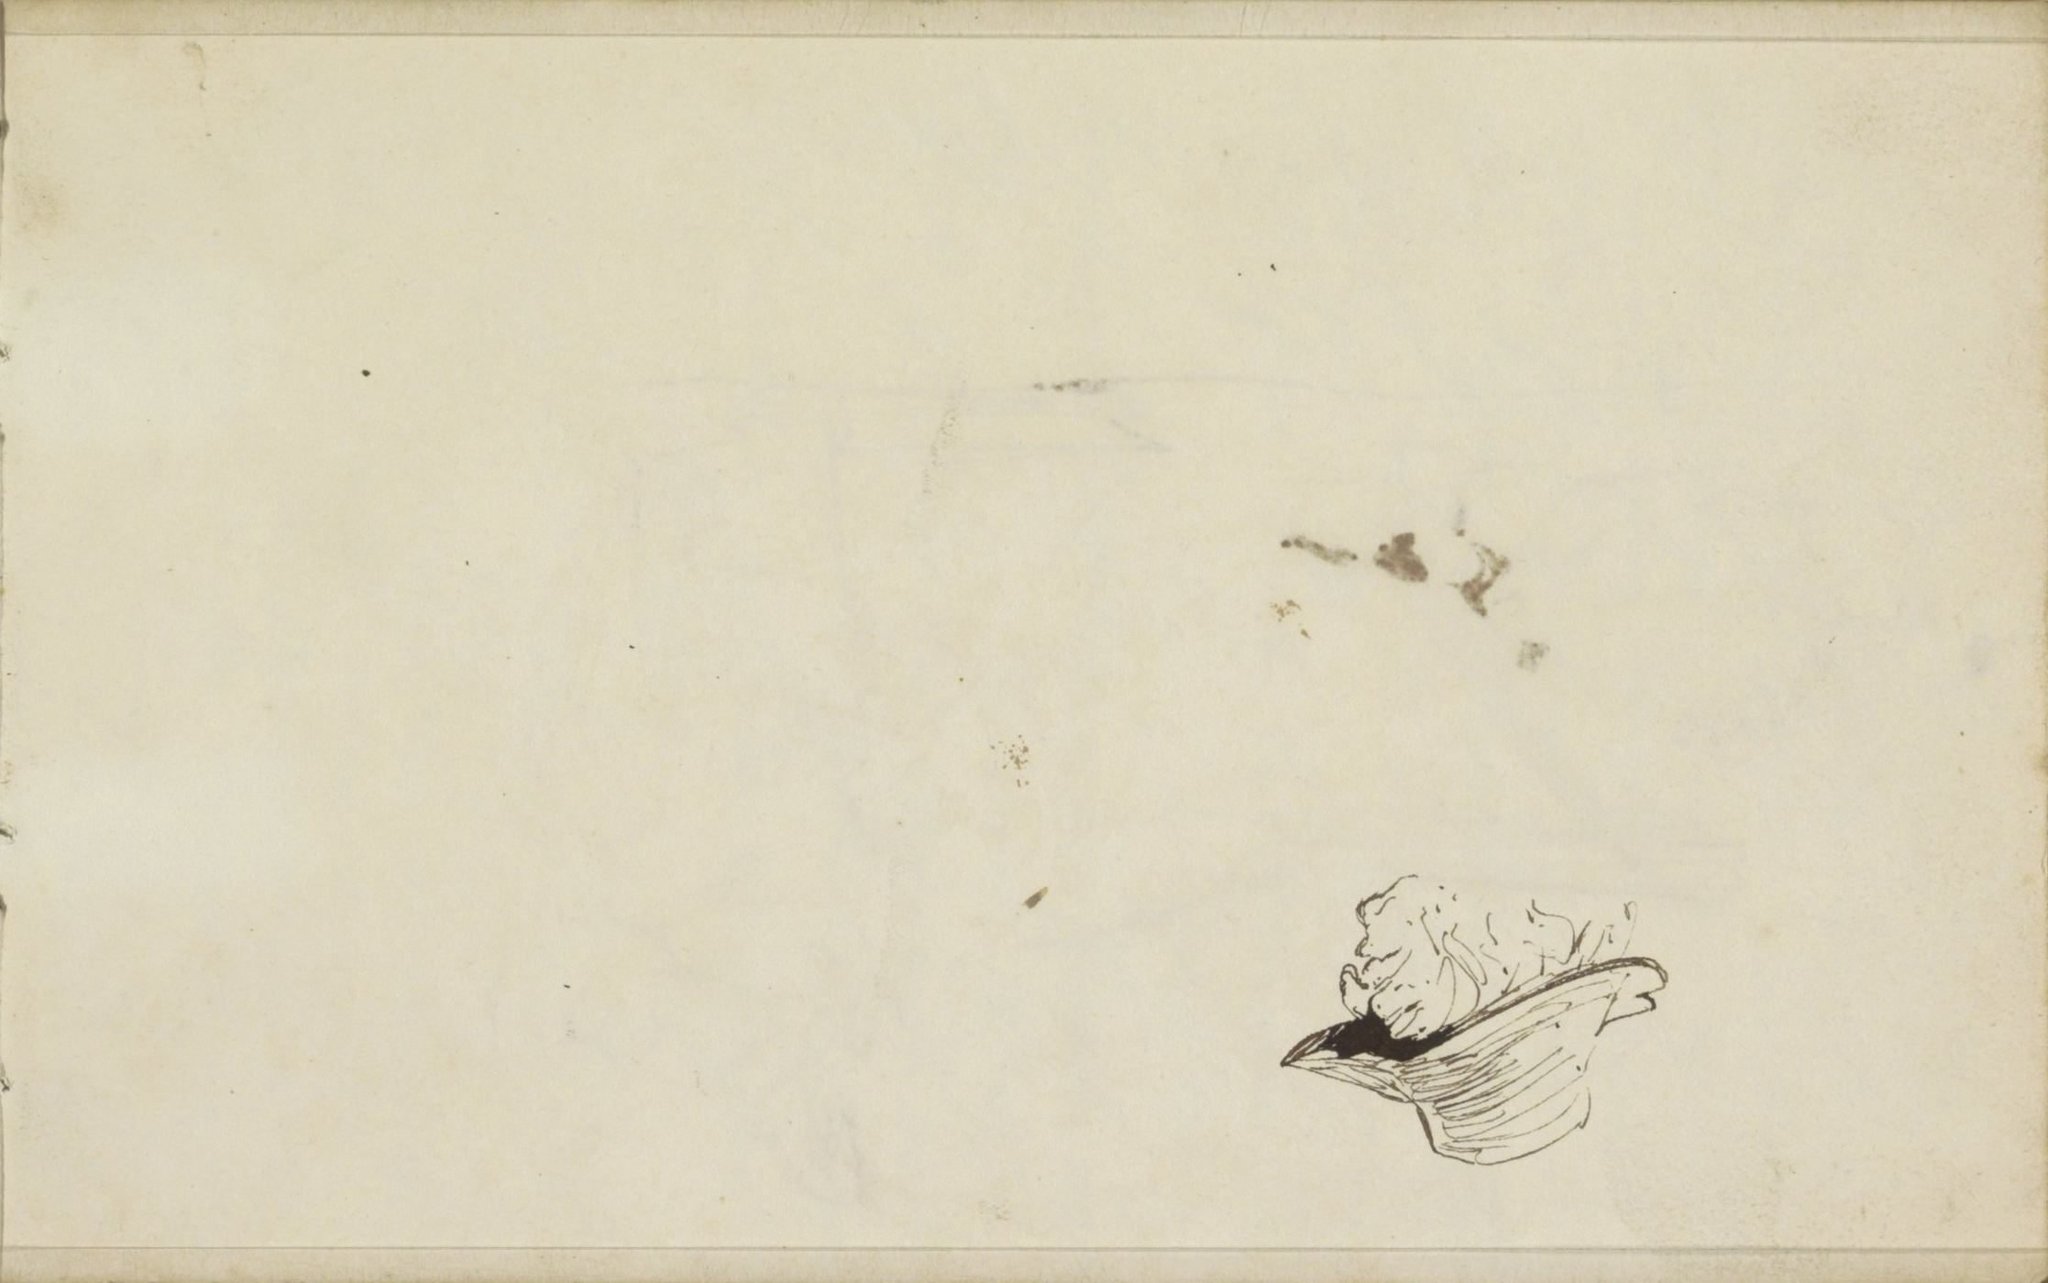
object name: sketchbook leaf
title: Kop met hoed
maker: johannes tavenraat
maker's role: draughtsman, painter, print maker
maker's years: 1809-1881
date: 1839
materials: paper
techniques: pen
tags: head (human), head-gear: hat (+ men's clothes)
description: Blad 37 recto uit een schetsboek met 37 bladen.